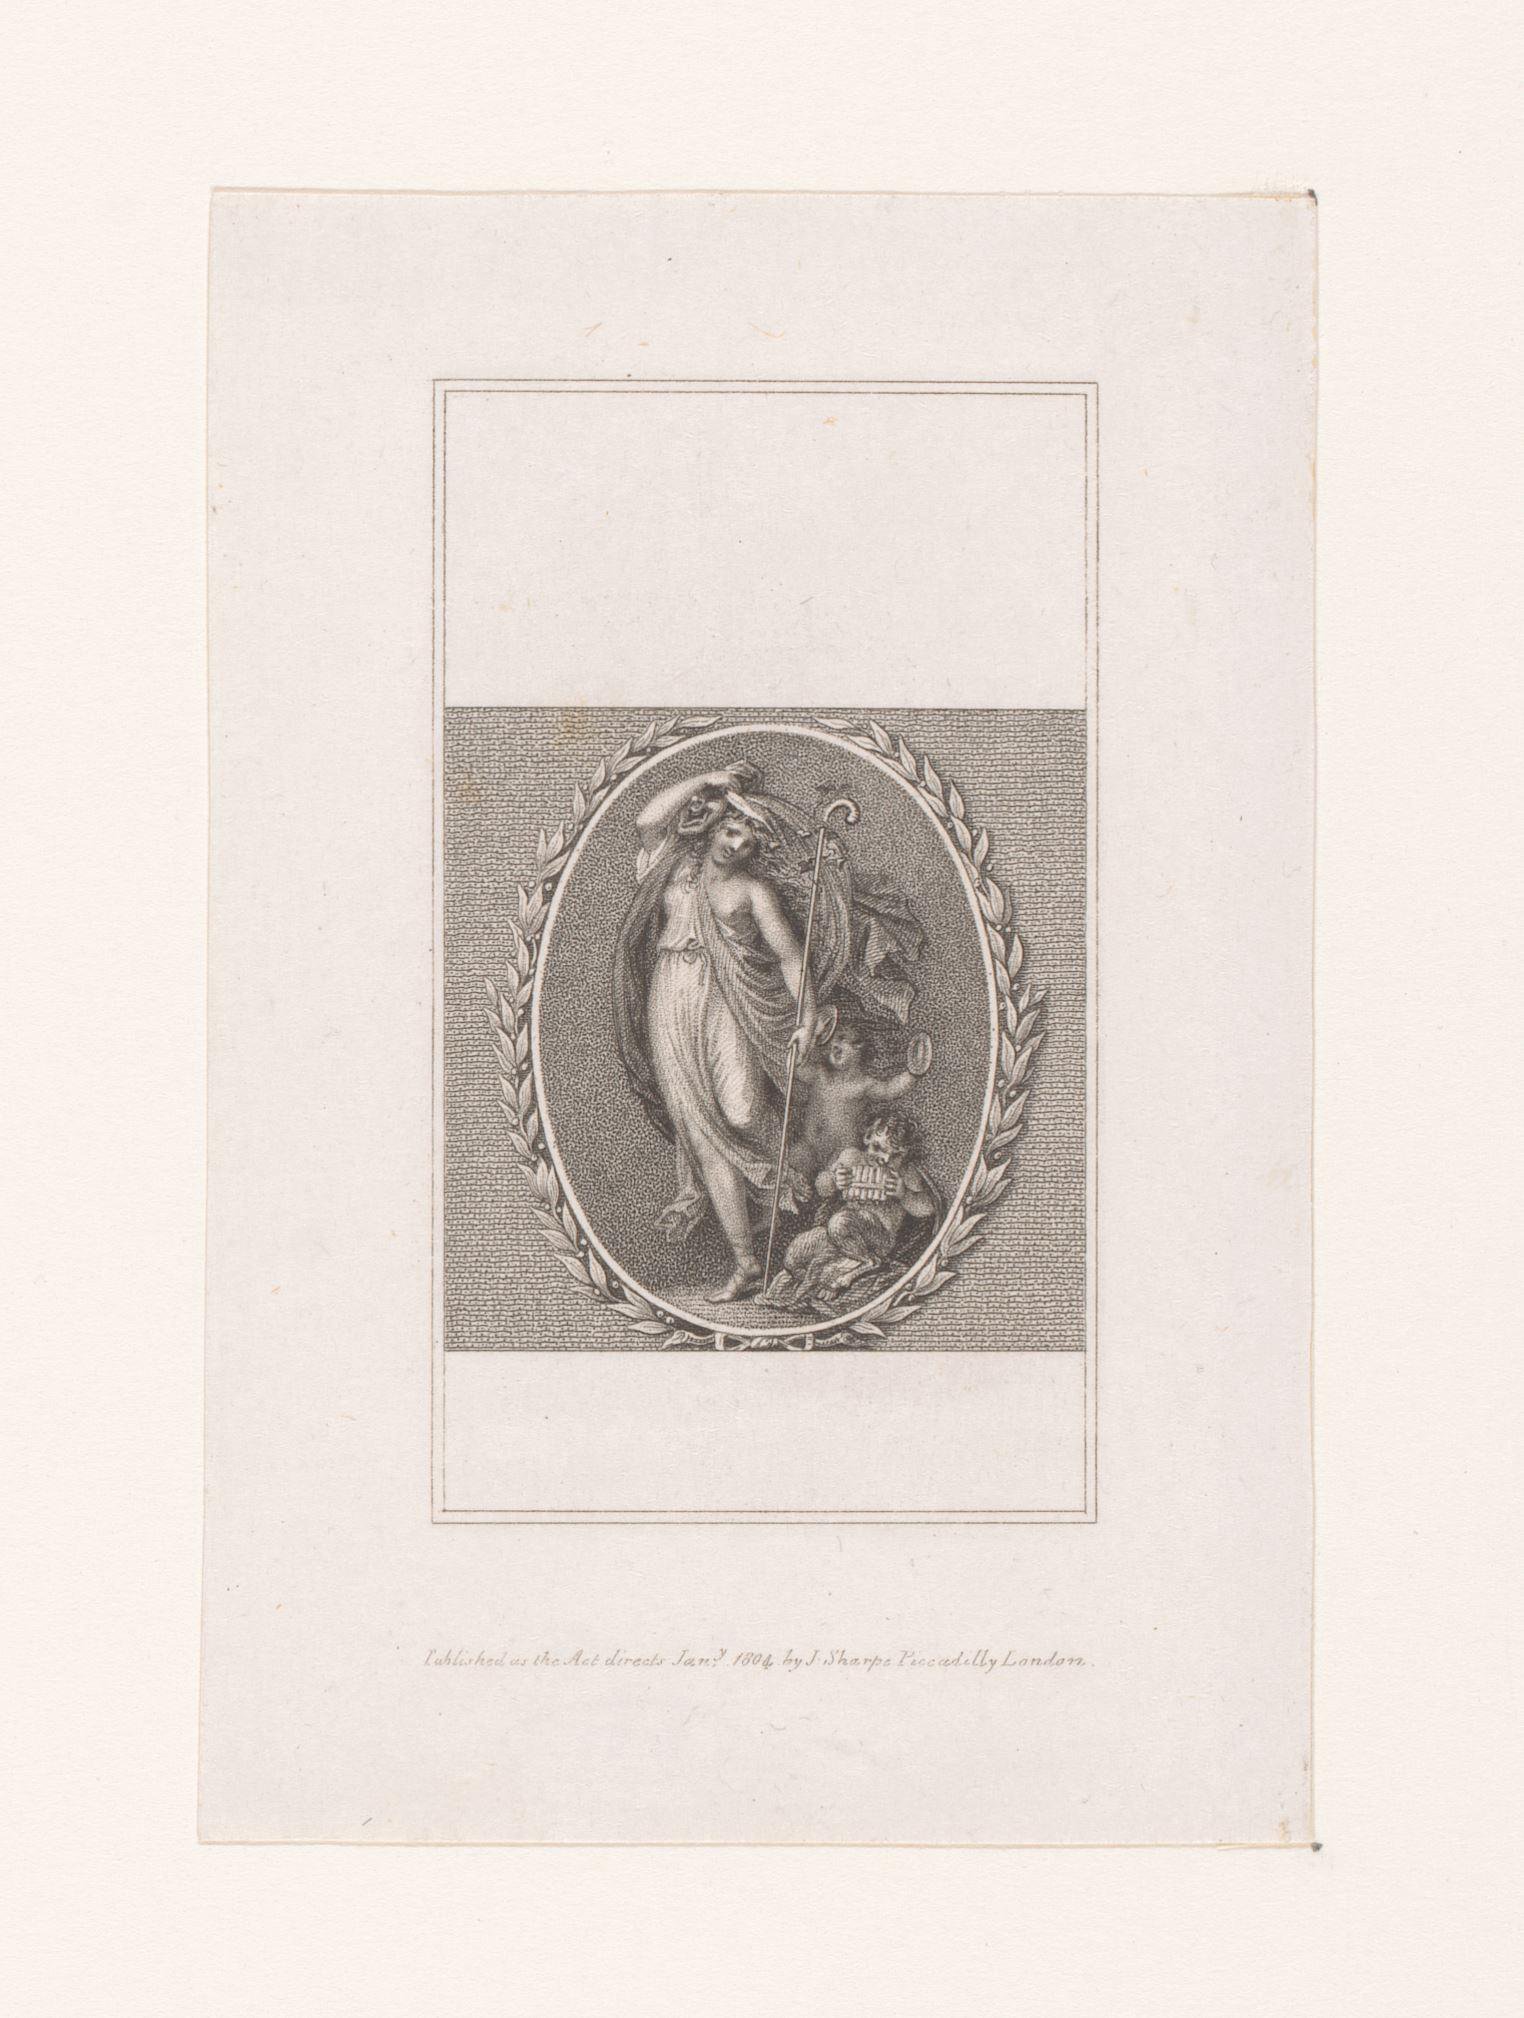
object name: print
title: Herderin met sluier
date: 1801-1804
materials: paper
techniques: etching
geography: london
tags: satyr(s) (in general) - infancy, upbringing, herding, herdsman, herdswoman, shepherd, shepherdess, cowherd, etc., veil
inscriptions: collector's mark: Lugt 2228